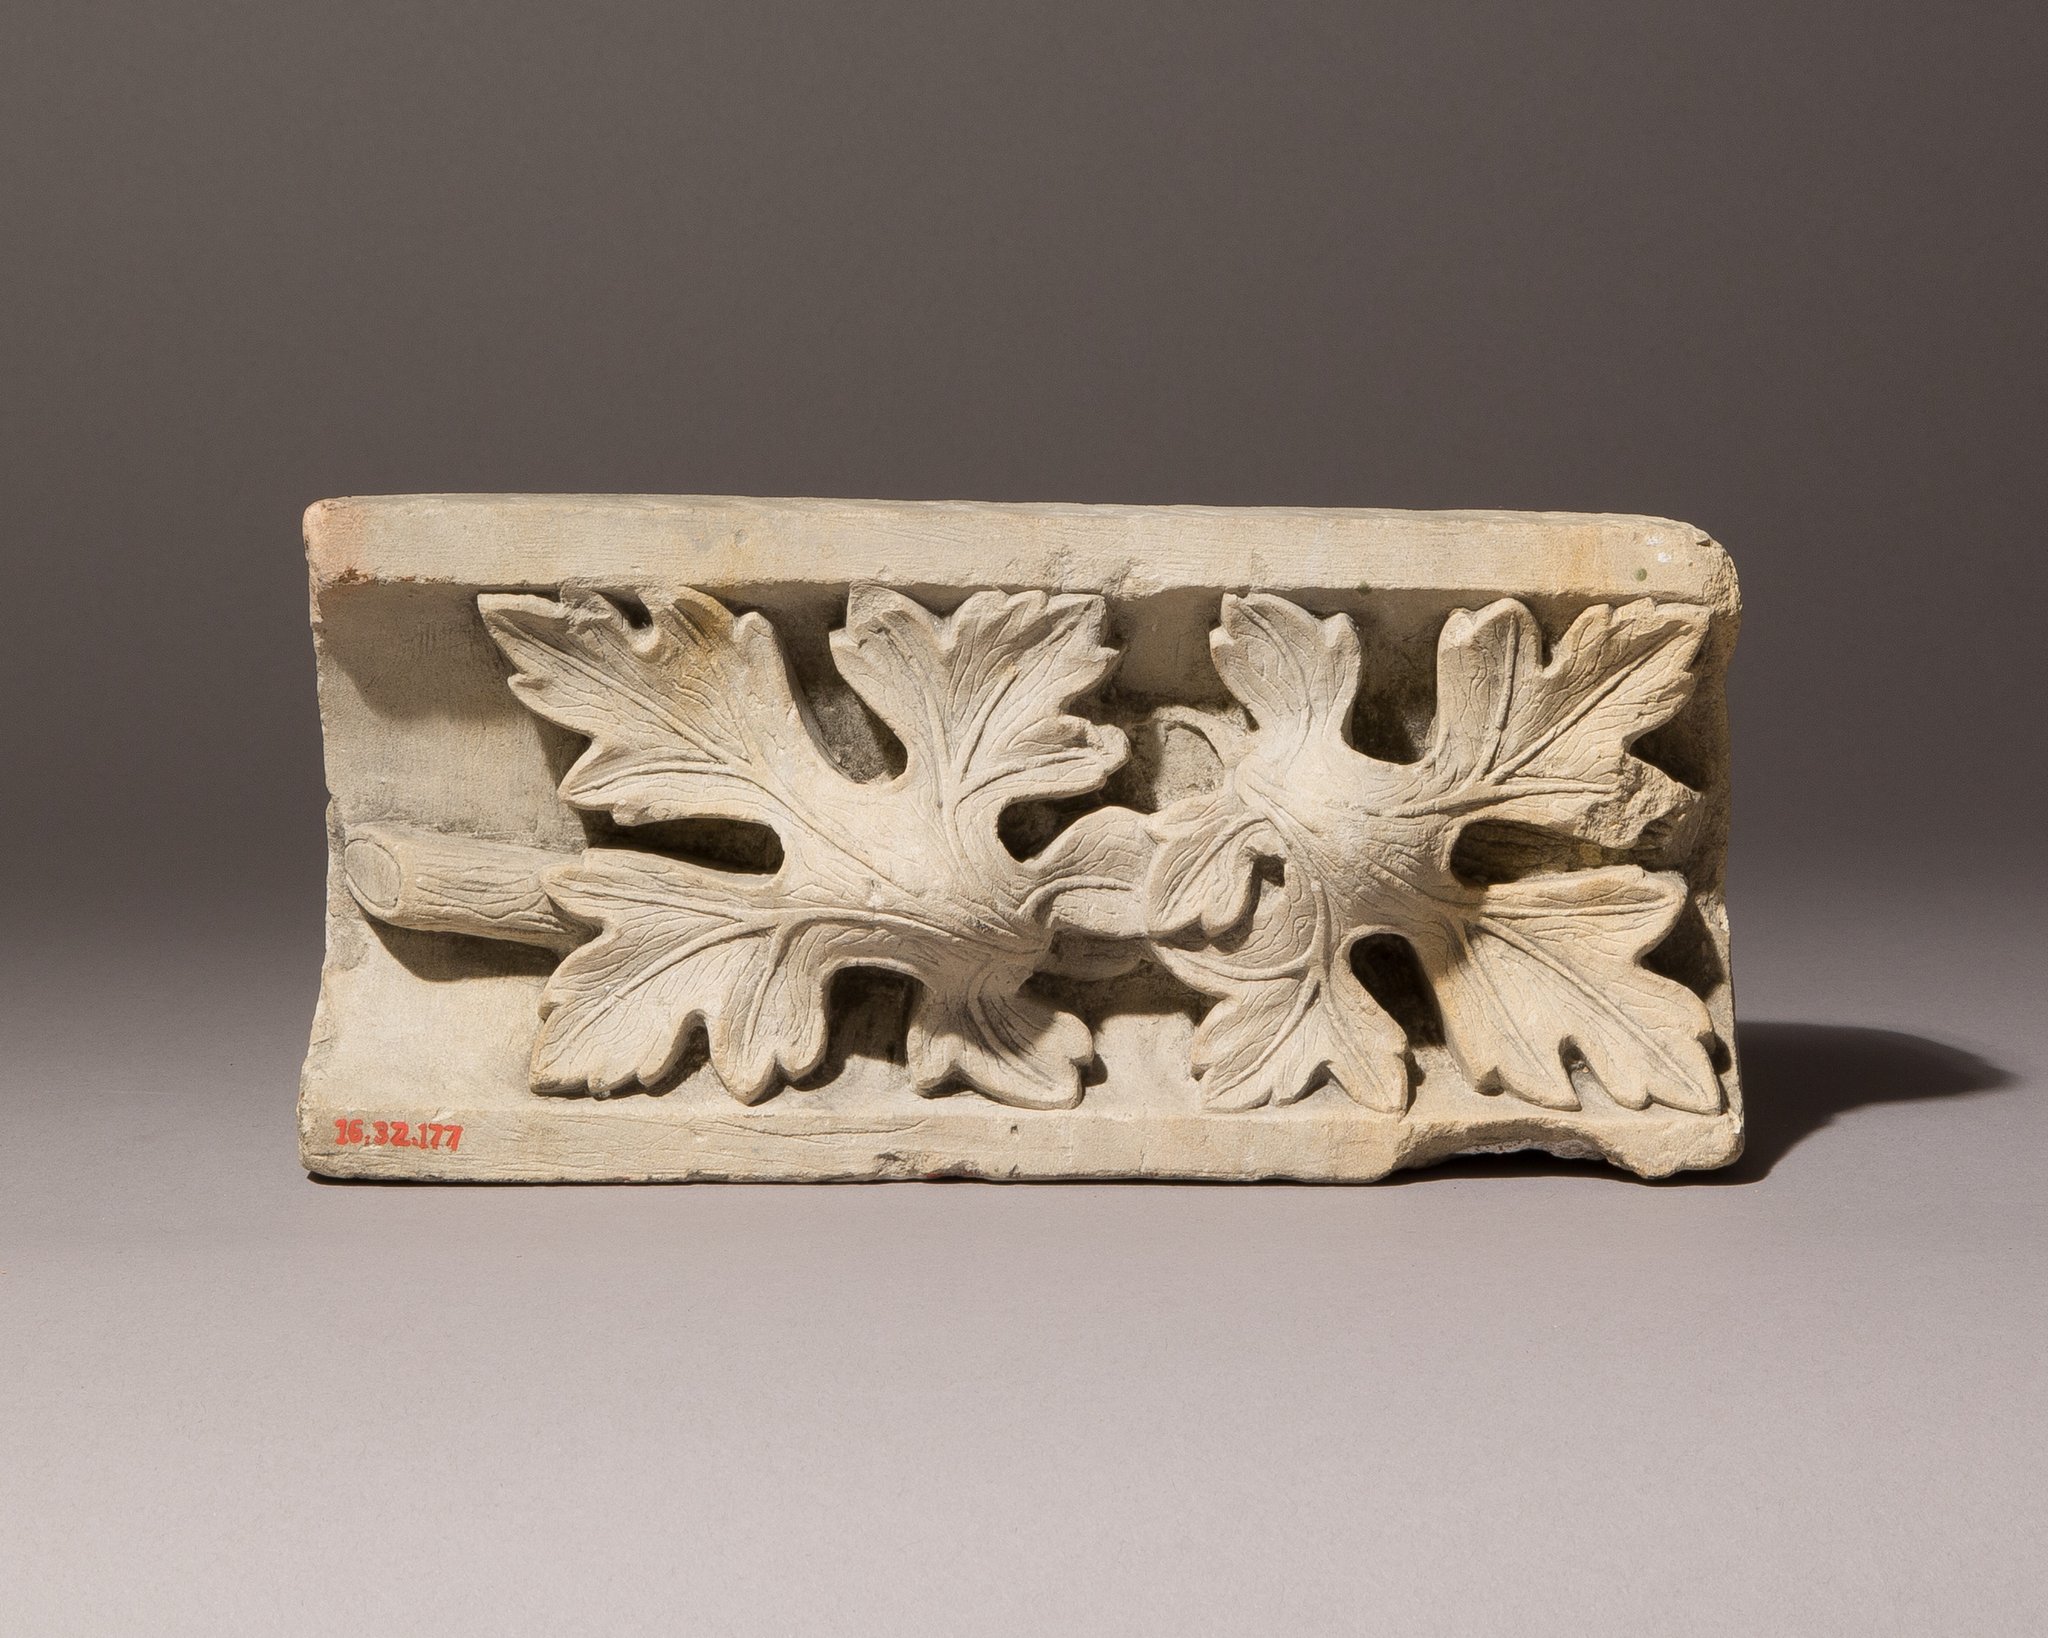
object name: fragment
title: Architectural Fragment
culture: french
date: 1301-1500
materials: stone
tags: leaves